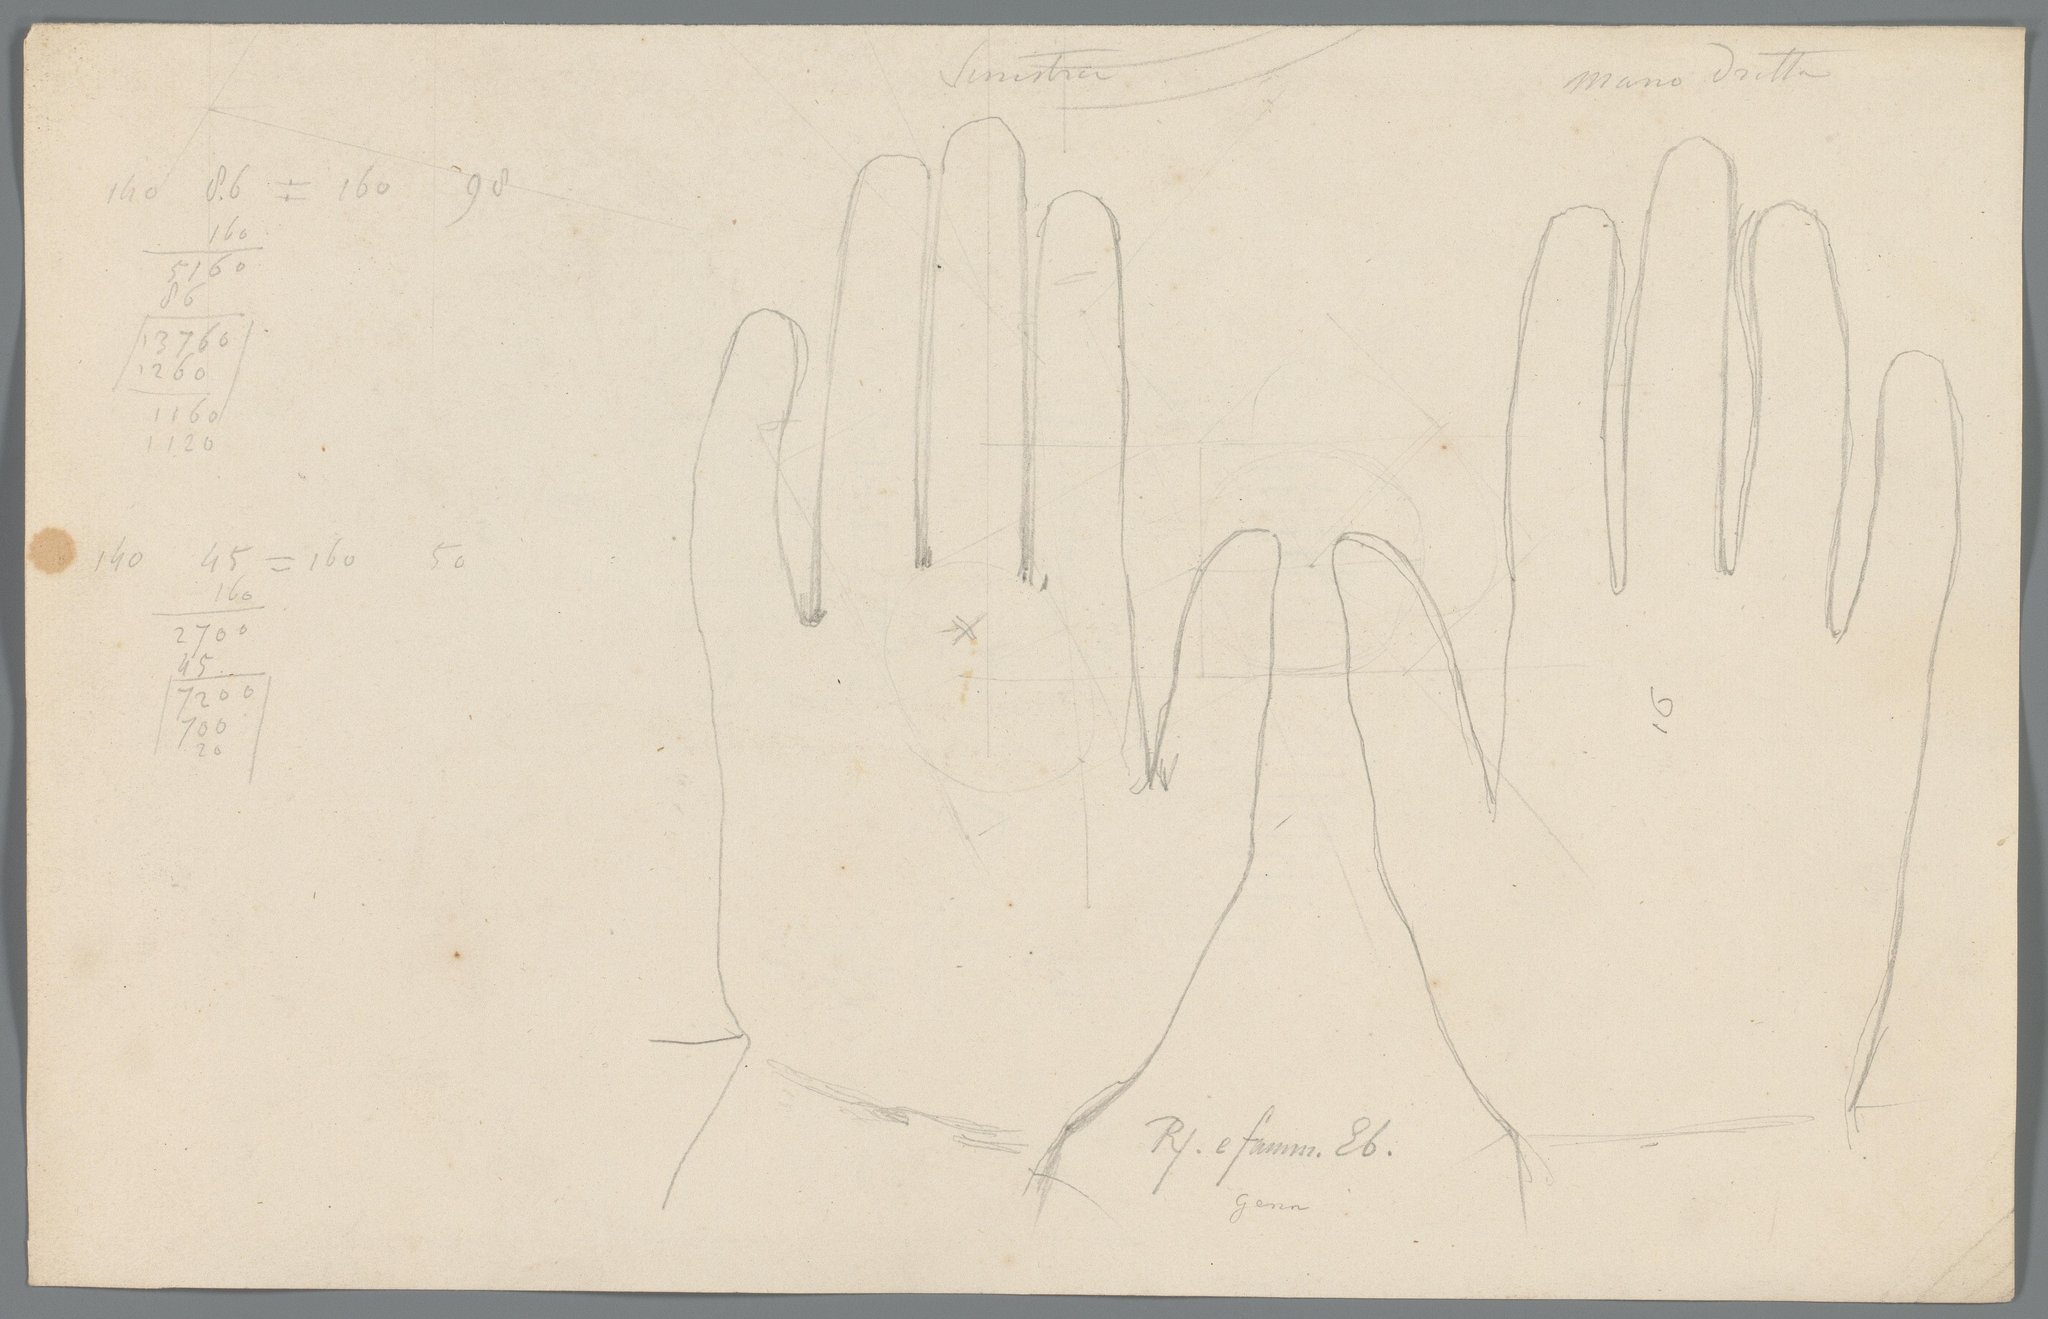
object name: drawing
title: Omtrek van twee handen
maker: jacobus everhardus josephus van den berg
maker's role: draughtsman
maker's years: 1802-1861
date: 1812-1861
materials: paper, pencil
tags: postures and gestures of arms and hands in general